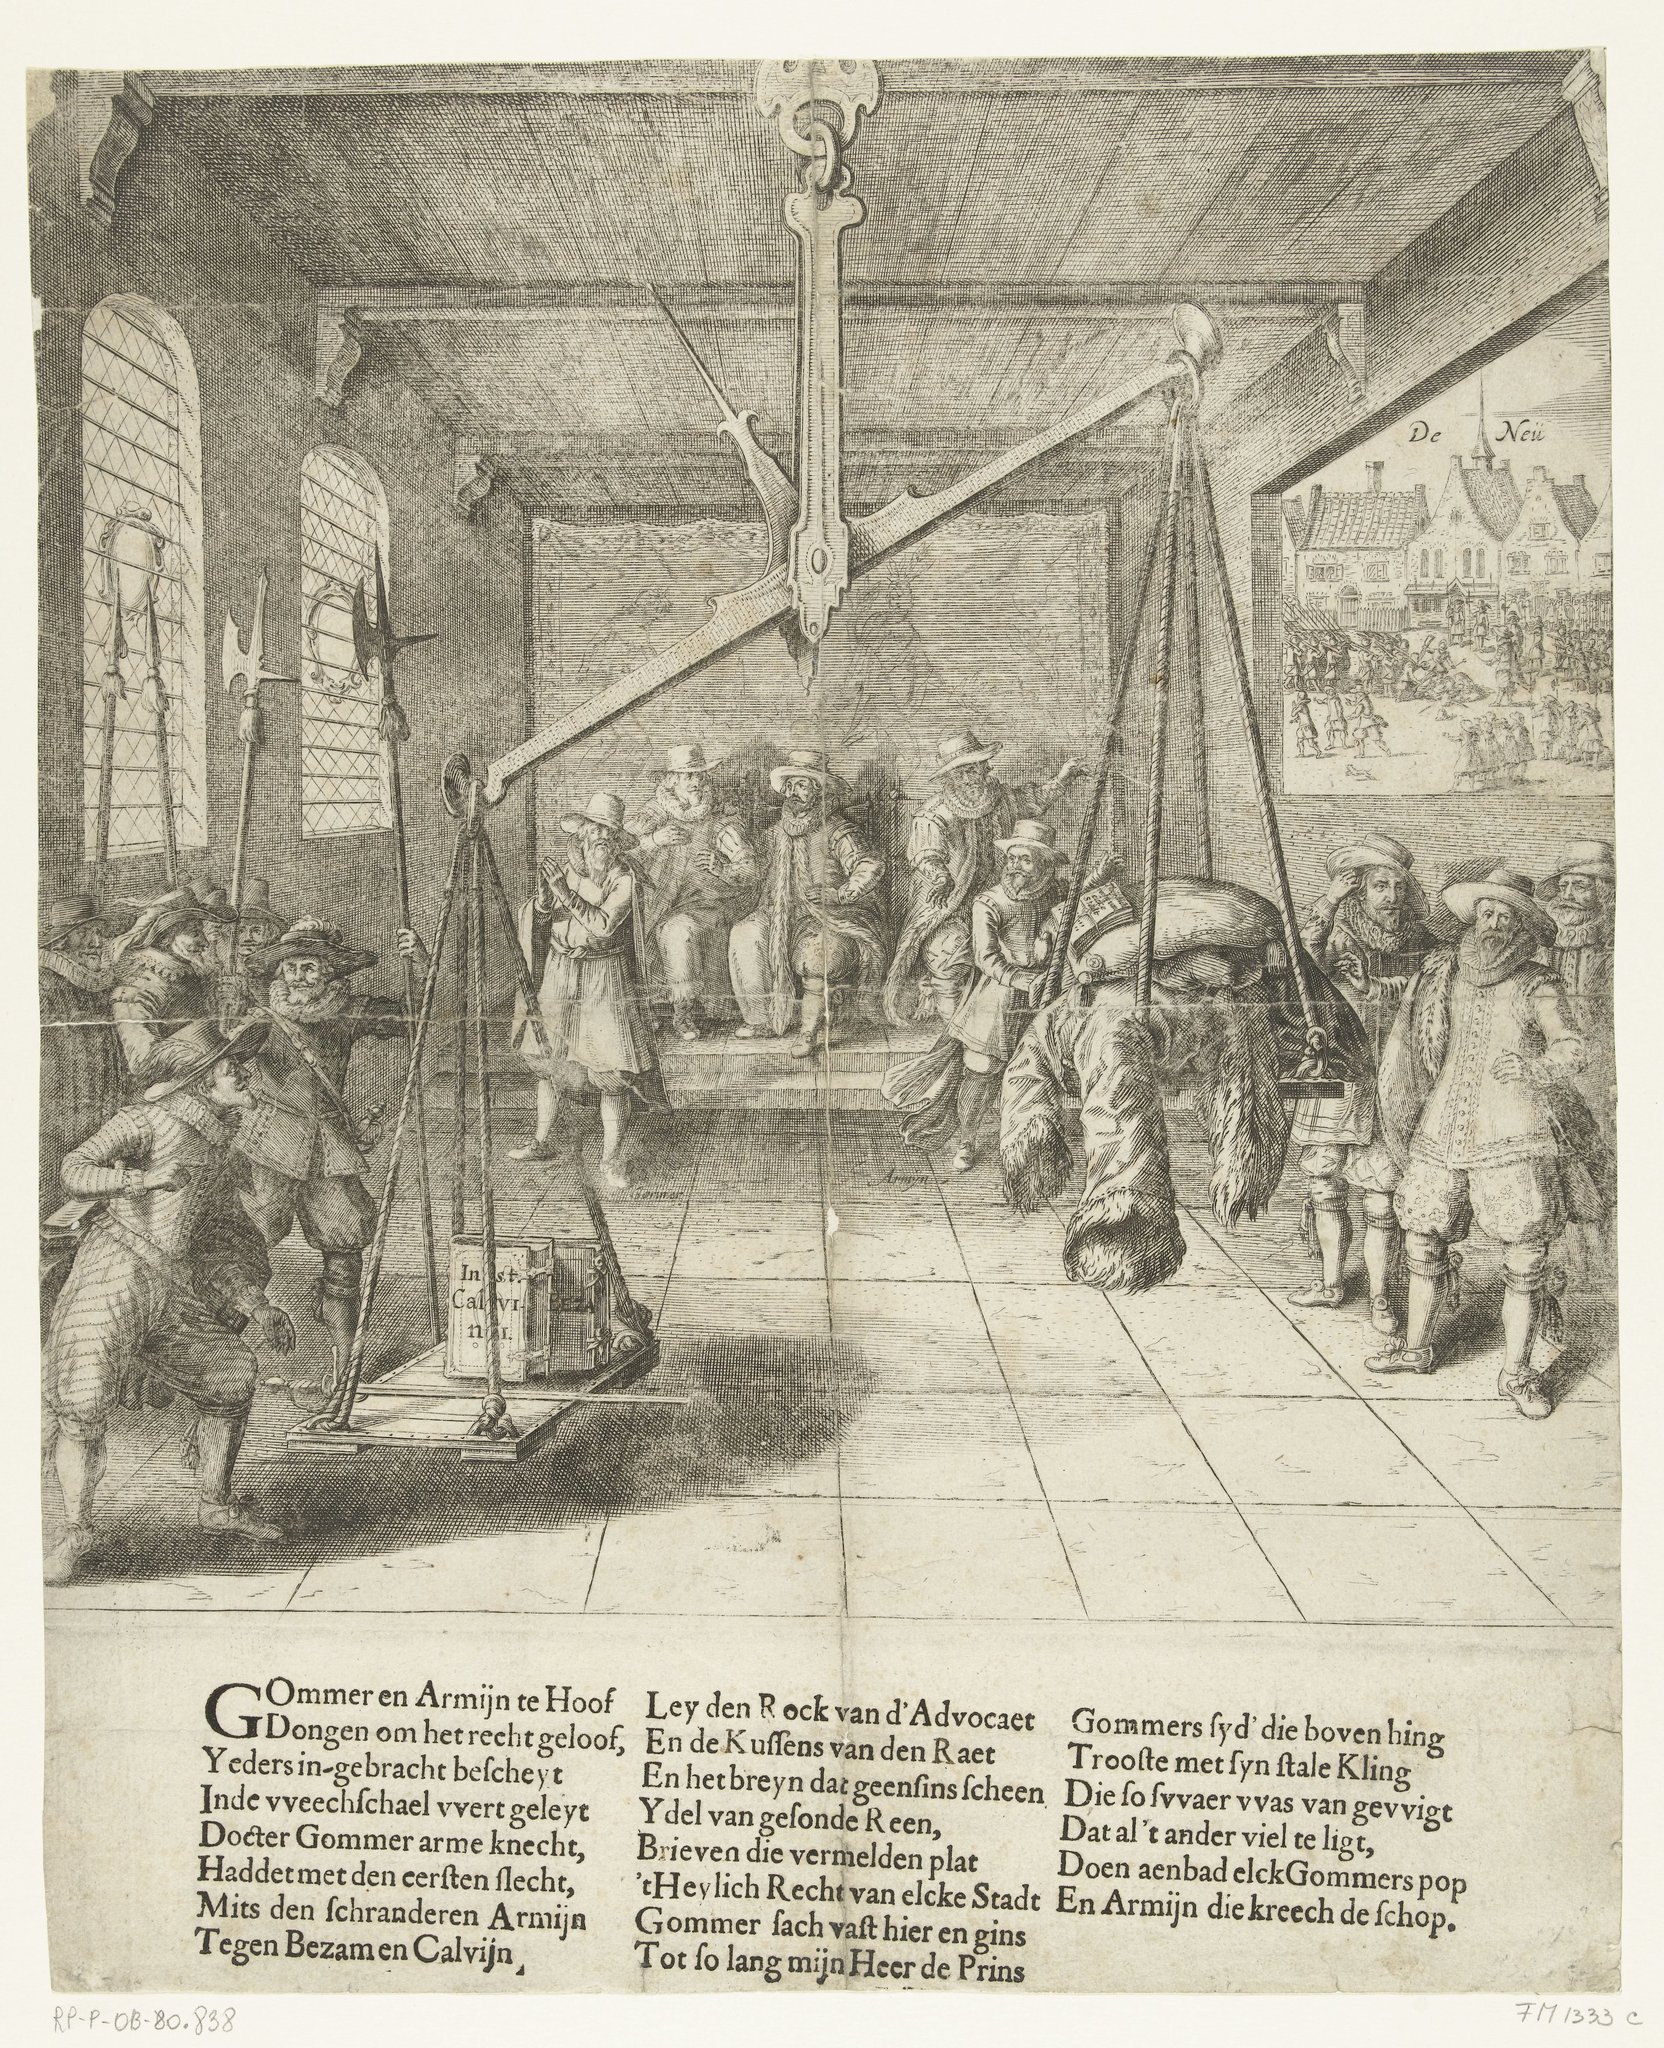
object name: print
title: De Weegschaal, 1618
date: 1618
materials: paper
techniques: engraving, letterpress printing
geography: northern netherlands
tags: johan van oldenbarnevelt, maurice (prince of orange), bruges, scales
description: Politieke allegorie op de overwinning van de contraremonstranten dankzij het ingrijpen van prins Maurits, 1618. De voorstelling toont een interieur met een grote weegschaal. Hierop worden, in aanwezigheid van Gomarus, Arminius, Johan van Oldenbarnevelt en anderen, de argumenten van de contraremonstranten en de remonstranten tegen elkaar afgewogen. Maurits doet de balans ten gunste van de contraremonstranten doorslaan door zijn zwaard op de weegschaal te leggen. Op de achtergrond door een venster de afdanking van de waardgelders door Maurits op de Neude te Utrecht. Onder de voorstelling in drie kolommen een vers van Vondel.